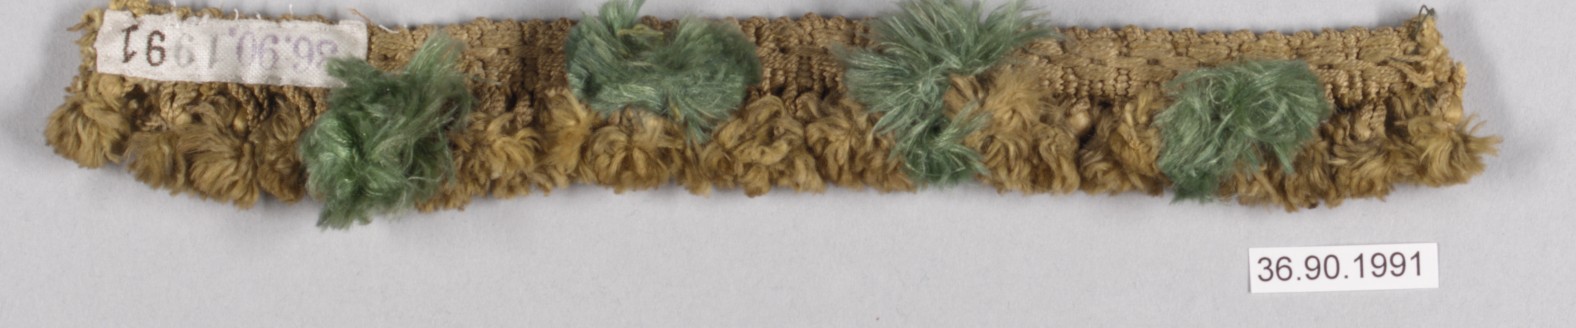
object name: fringe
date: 1601-1633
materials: silk